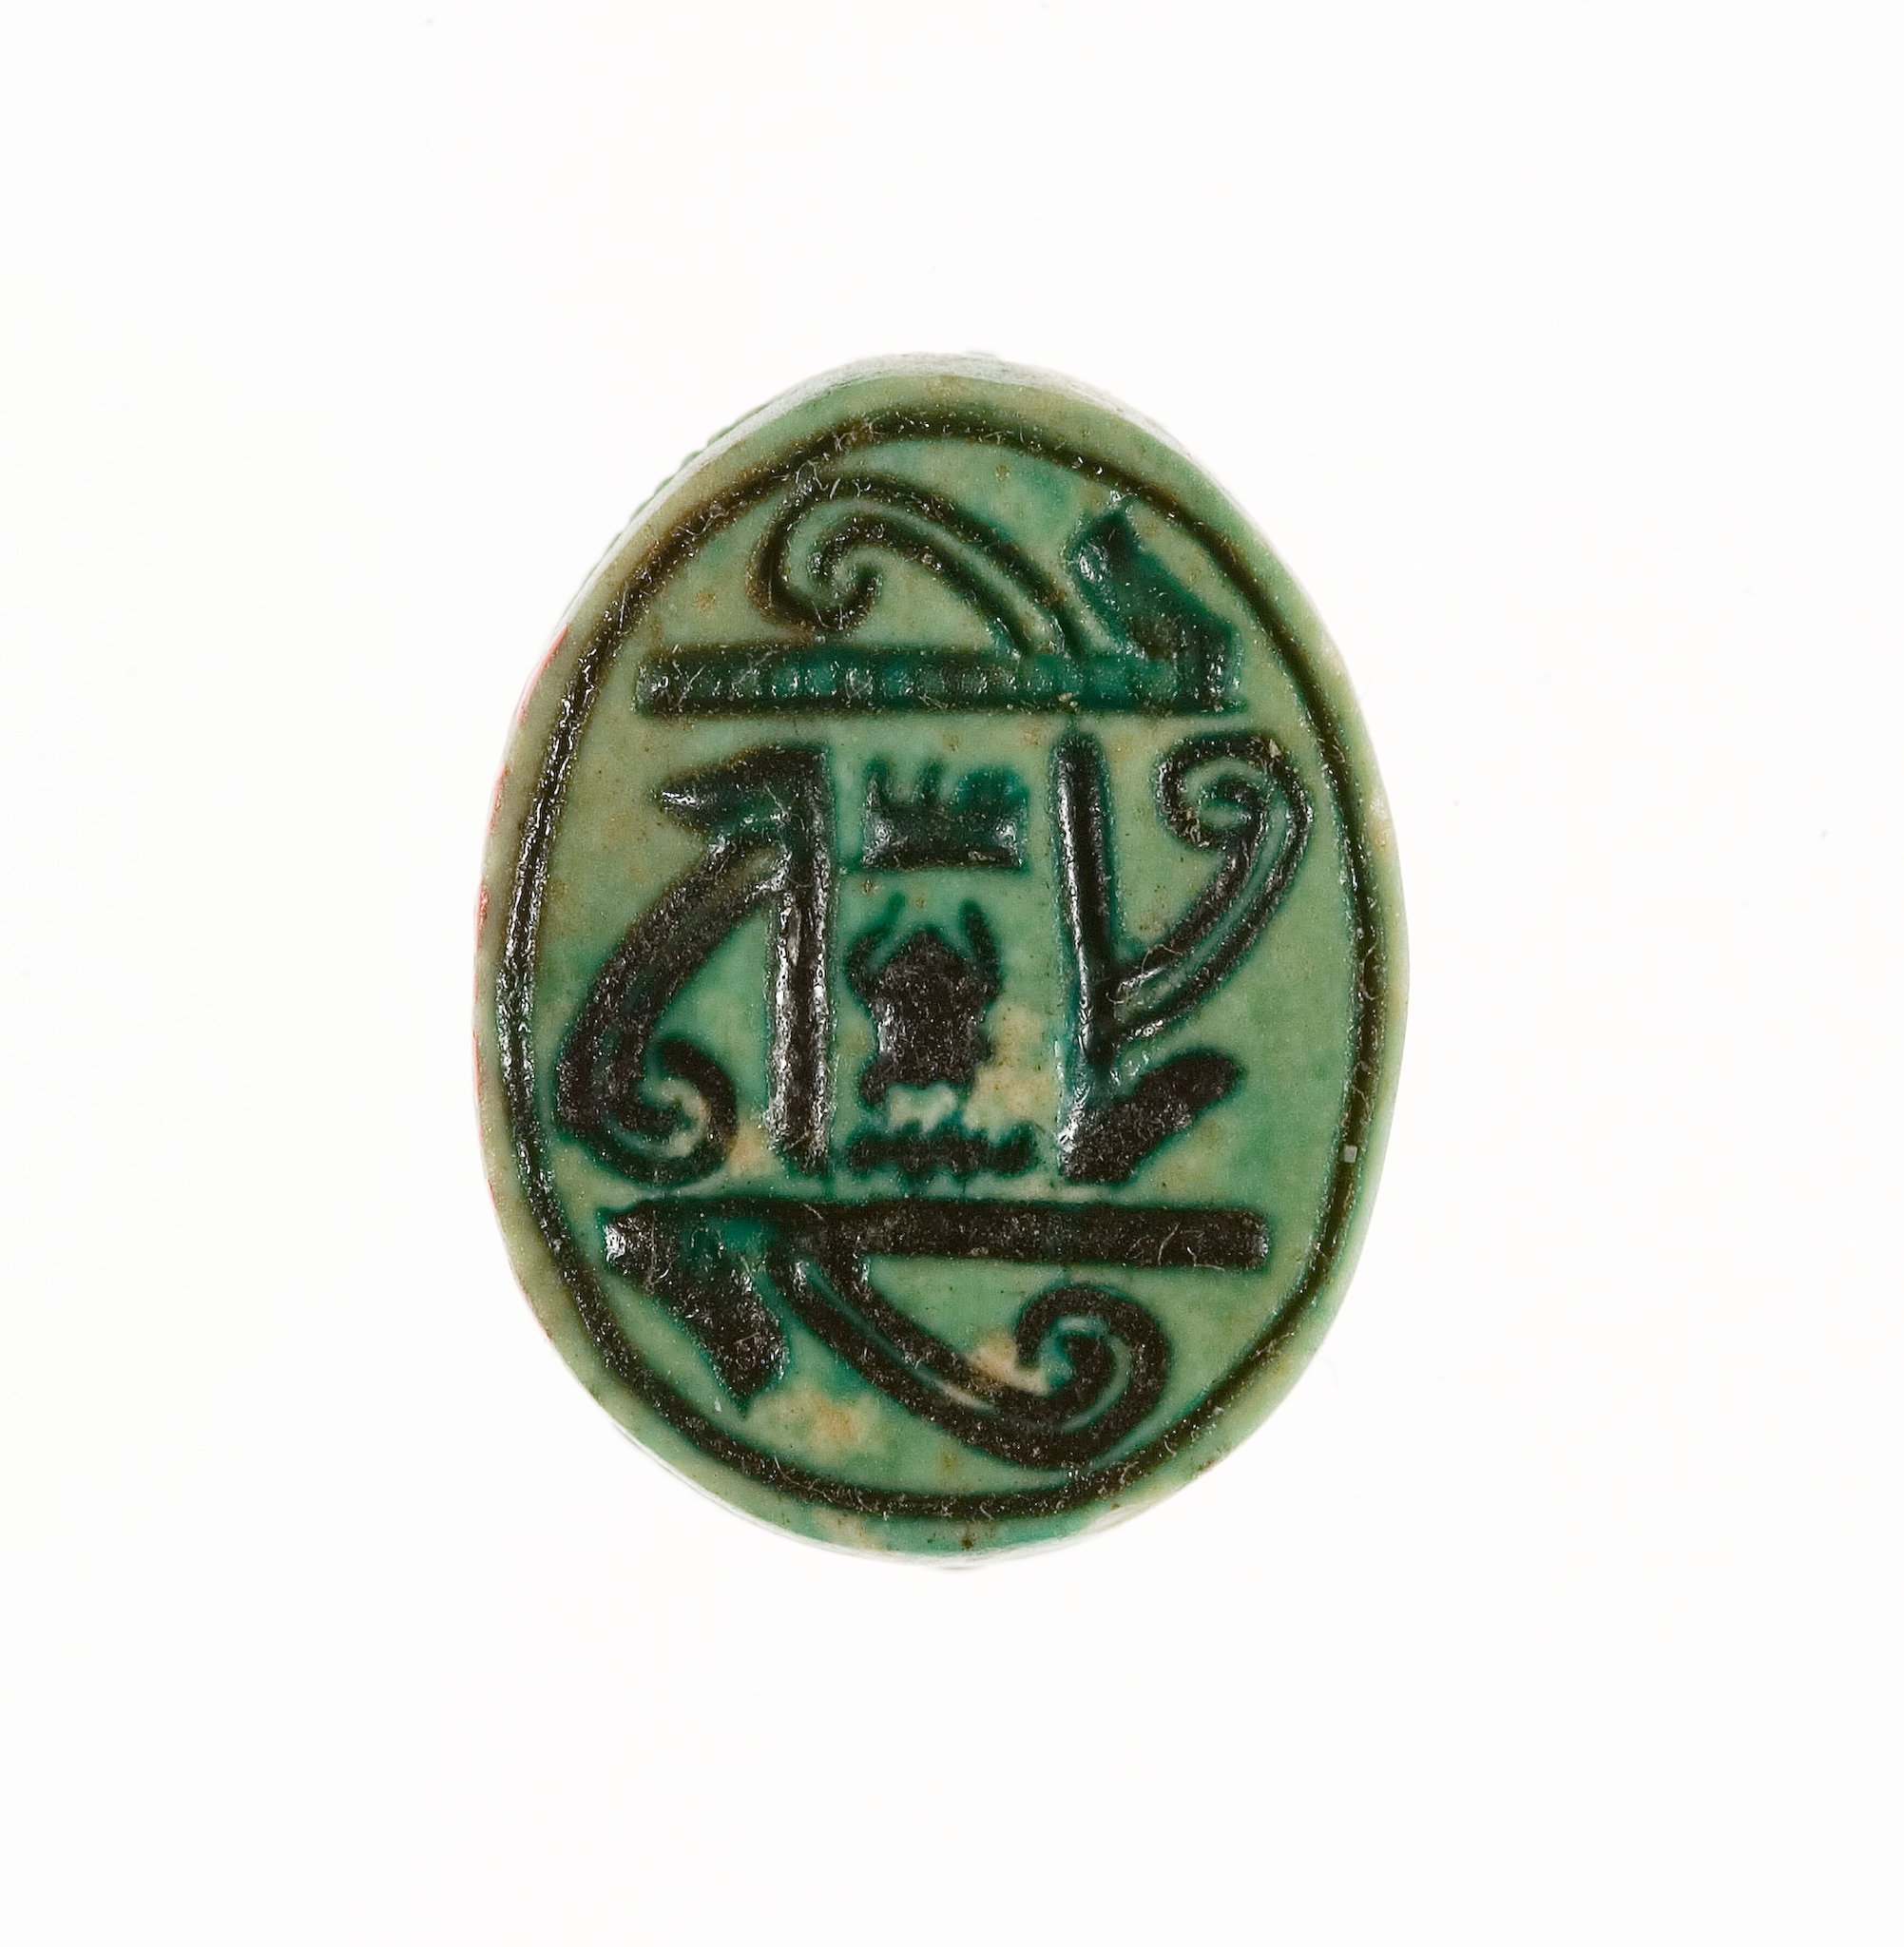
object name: scarab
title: Scarab Inscribed with the Throne Name of Thutmose III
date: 1479-1458 BCE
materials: stone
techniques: glazing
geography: egypt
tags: scarabs